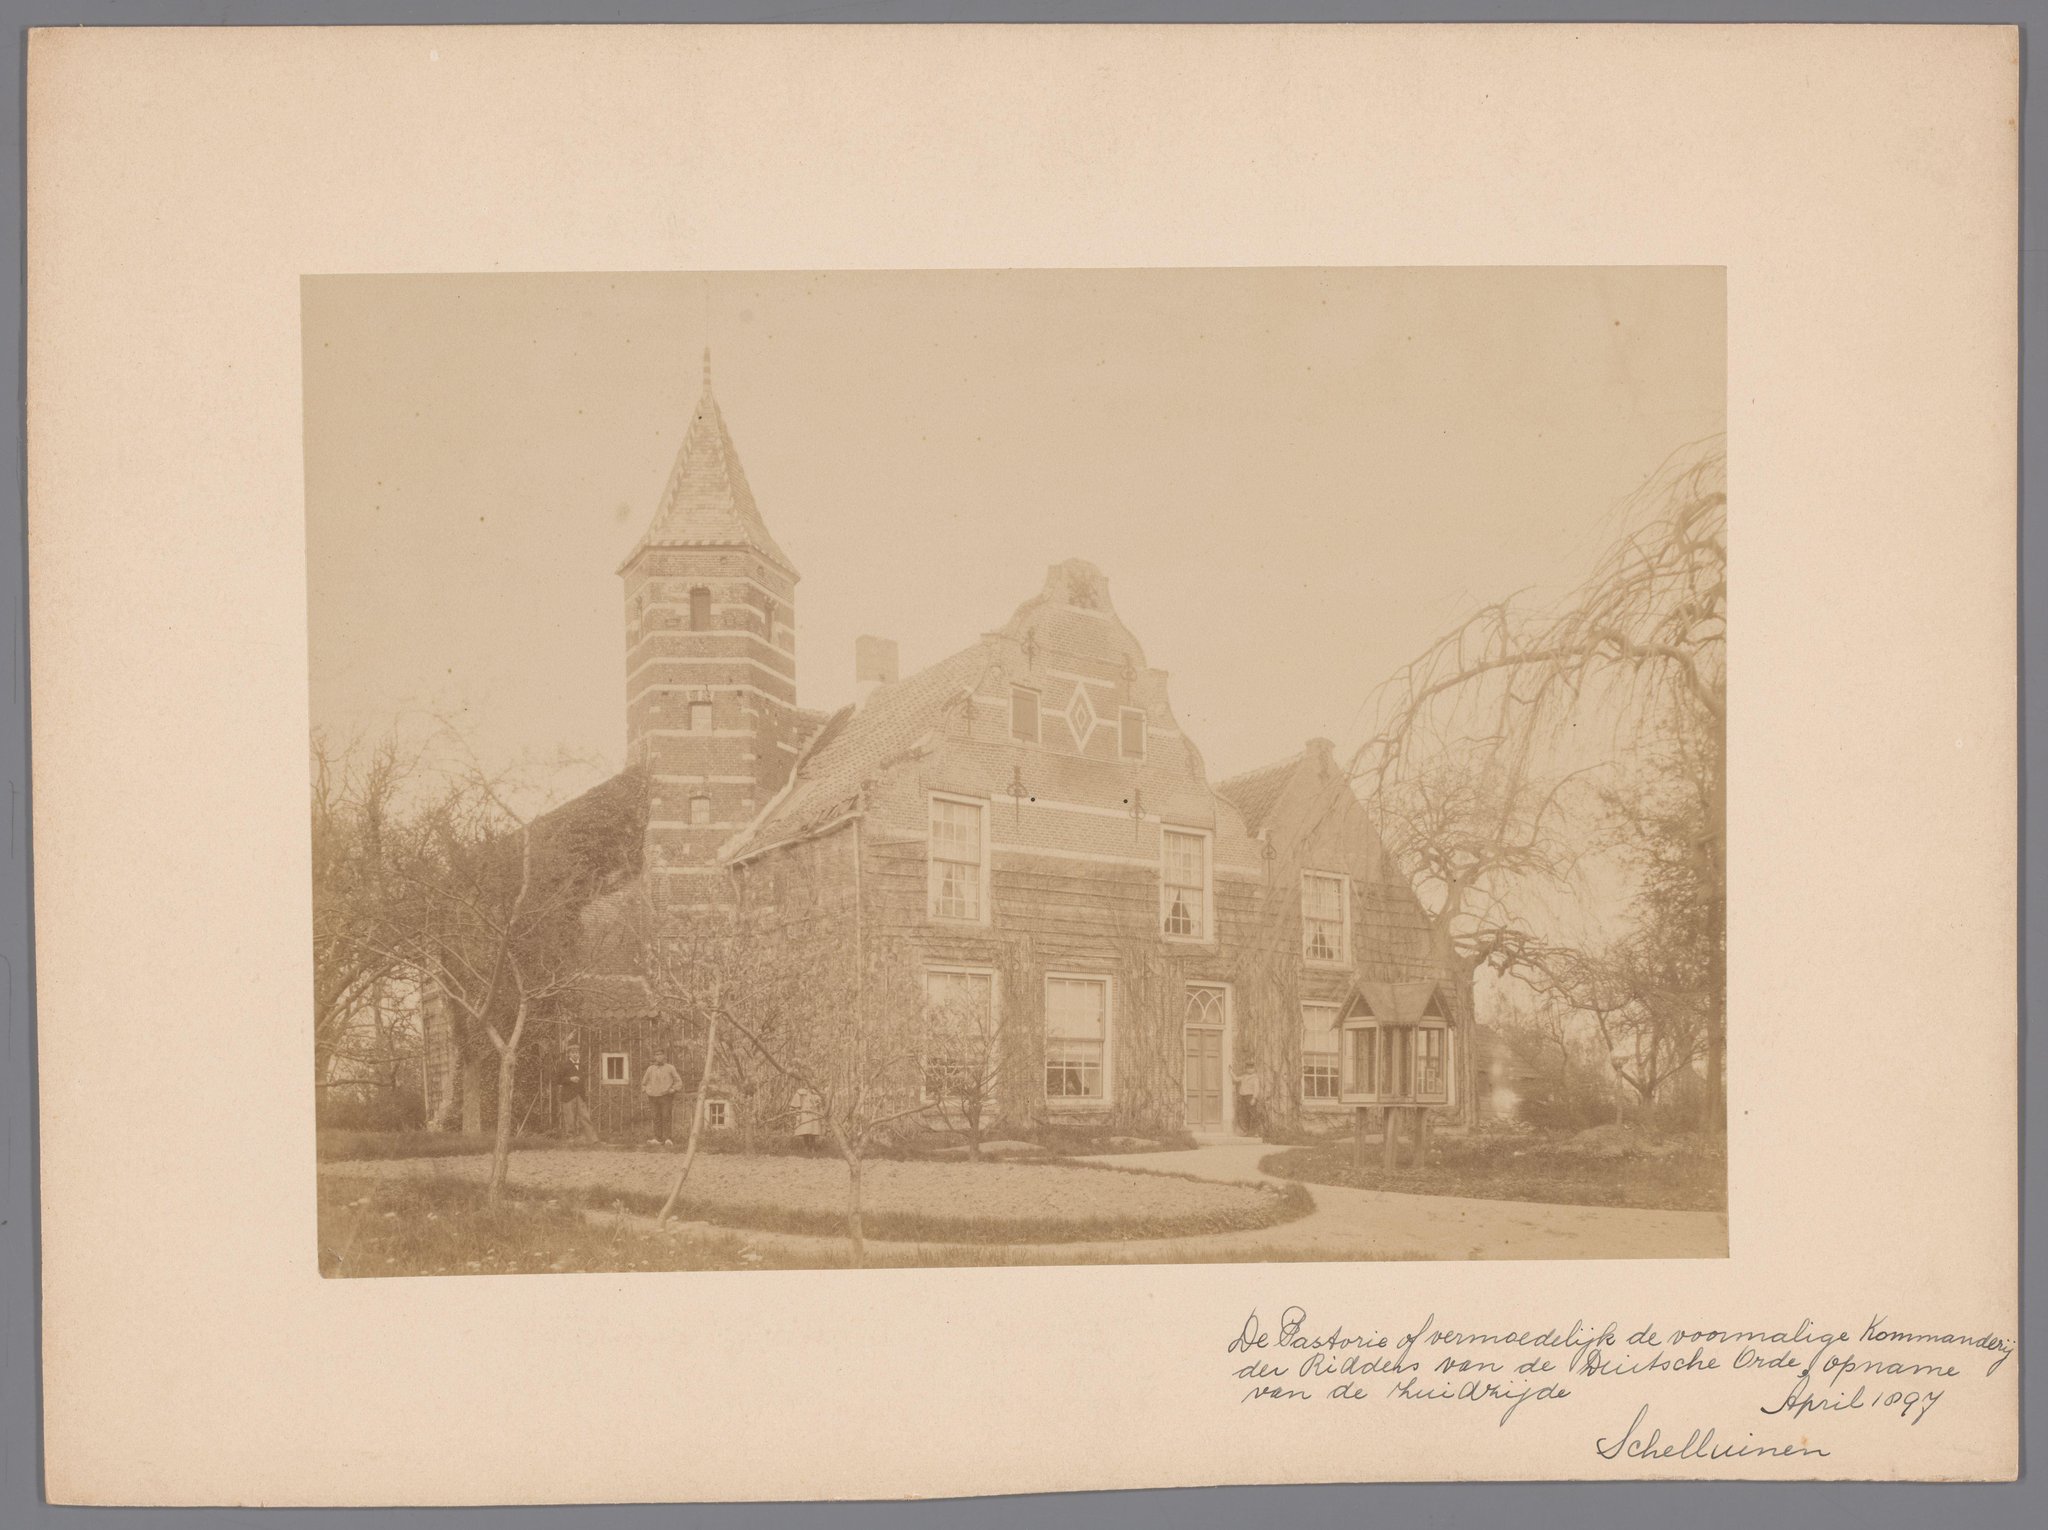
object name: photograph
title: Gezicht op de Pastorie Hervormde Kerk te Schelluinen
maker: anoniem (monumentenzorg)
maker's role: fotograaf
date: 1897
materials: cardboard, photographic support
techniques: albumen print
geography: schelluinen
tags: castle, church (exterior)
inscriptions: annotation: ‘De Pastorie of vermoedelijk de voormalige Kommanderij der Ridders van de Duitsche Orde, opname van de Zuidzijde/ April 1897/ Schelluinen’, annotation: ‘Schelluinen (Z.H.)/ De pastorie, of vermoedelijk de voormalige Kommanderij der Ridders van de Duitsche orde/ opname v/d Zuidzijde/ april 1897’